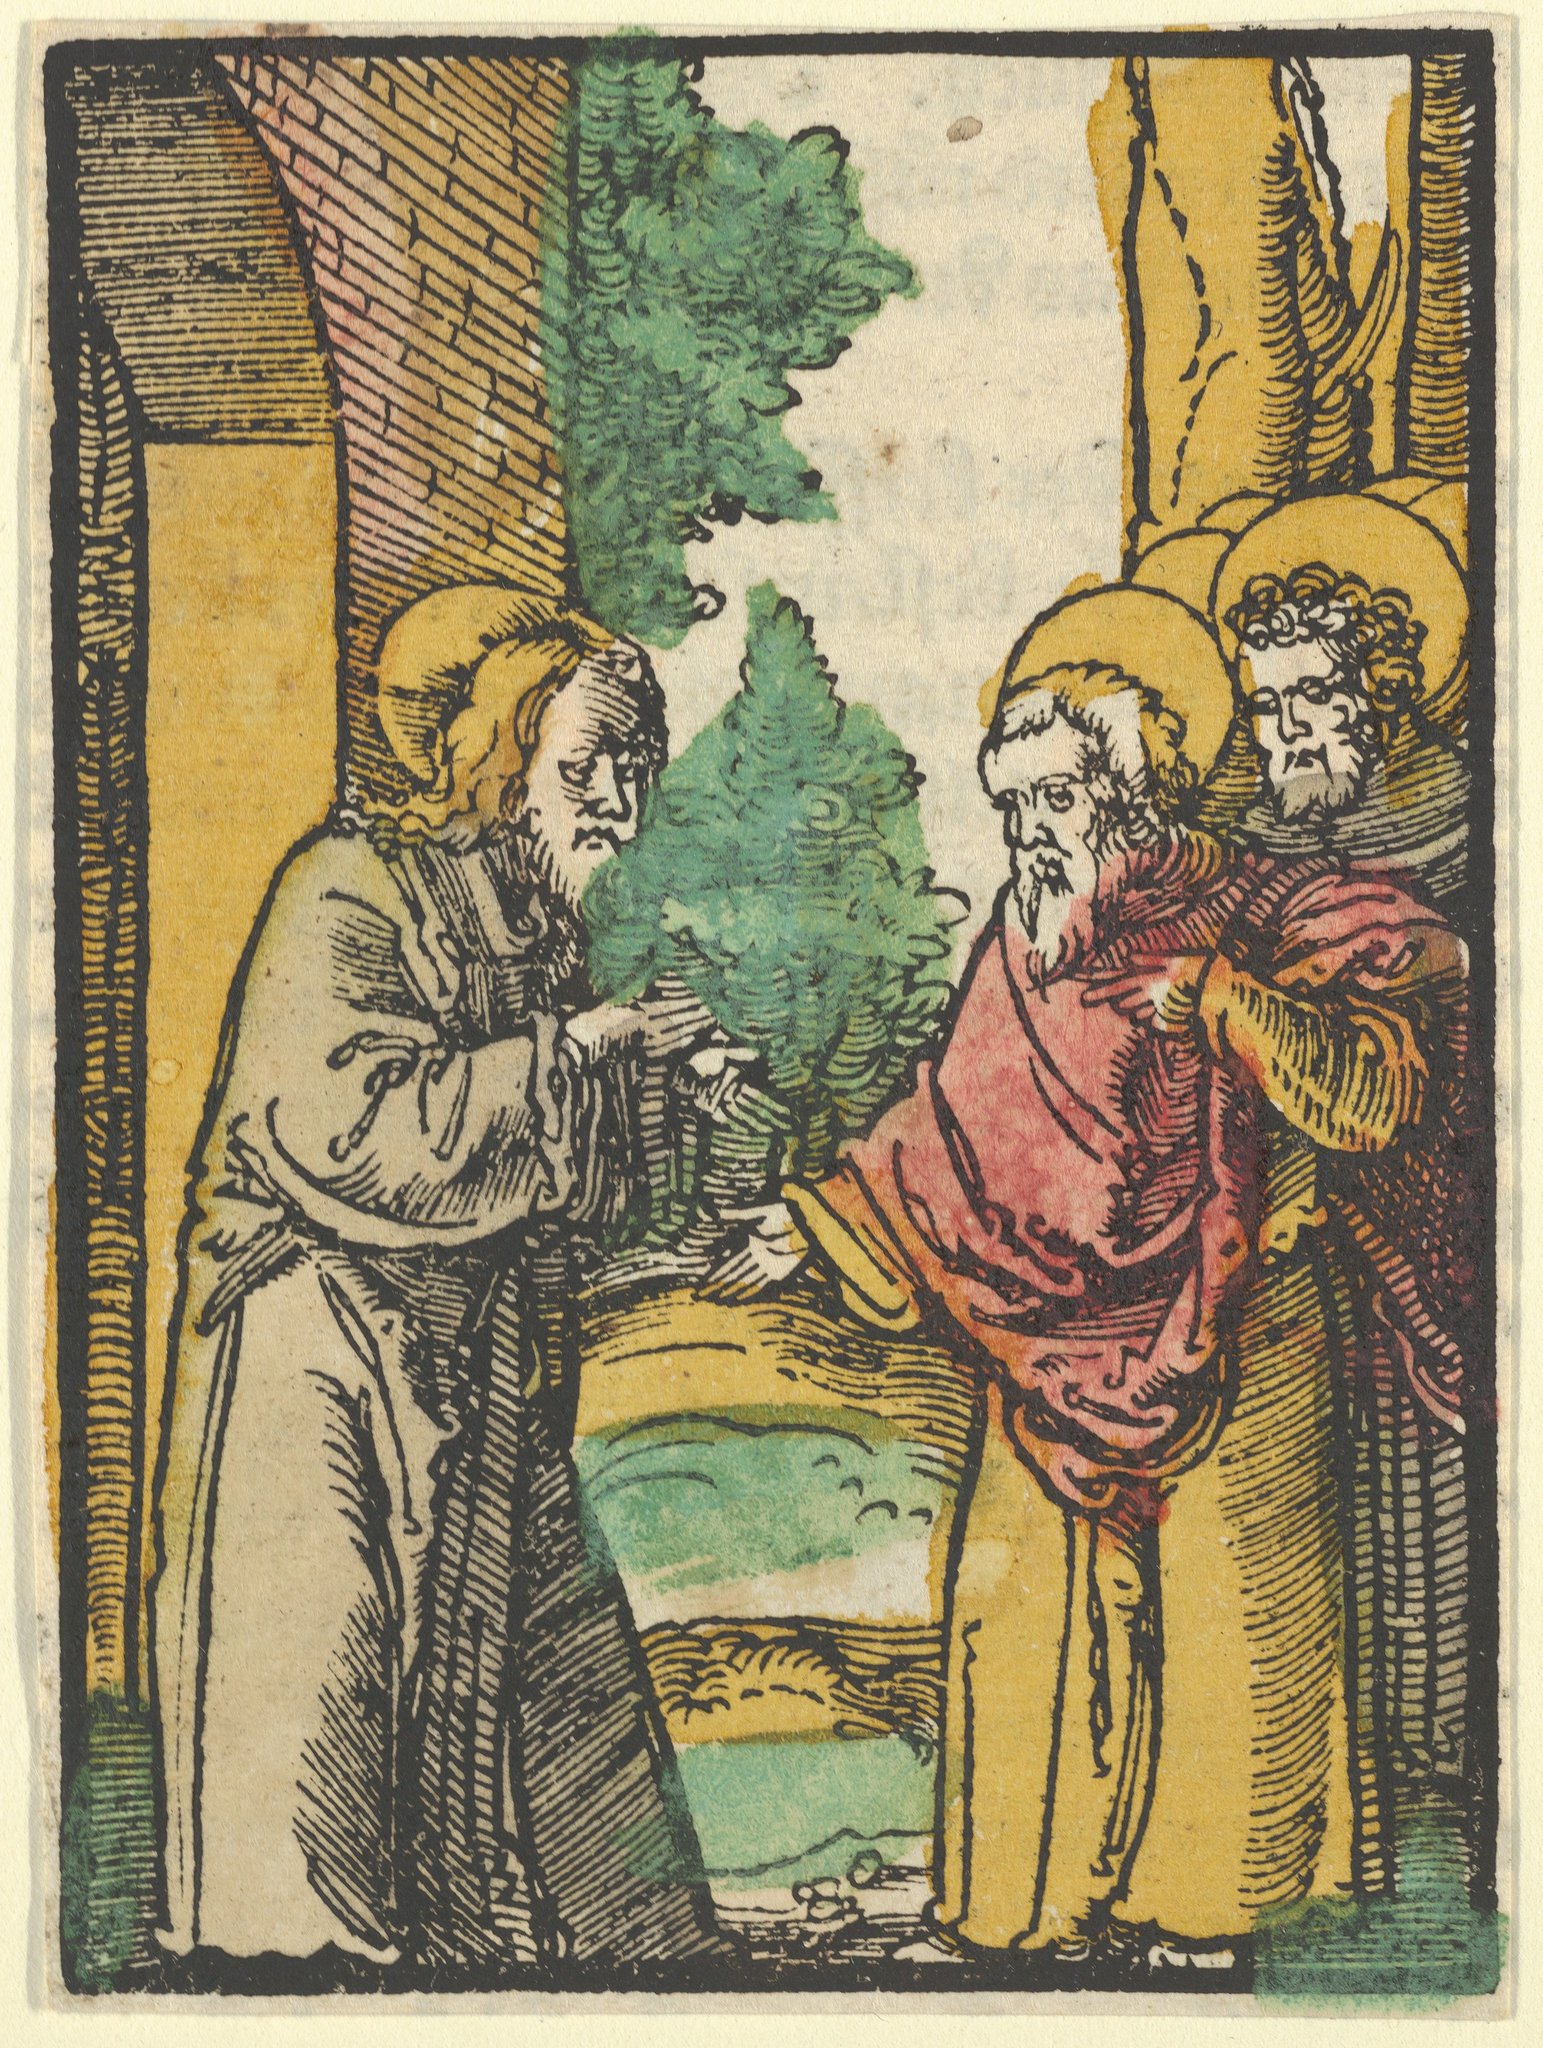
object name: print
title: Christ Talking to the Disciples, 3, from Das Plenarium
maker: hans schäufelein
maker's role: artist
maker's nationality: german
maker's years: 1480-1540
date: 1517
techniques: hand coloring, woodcut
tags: men,christ